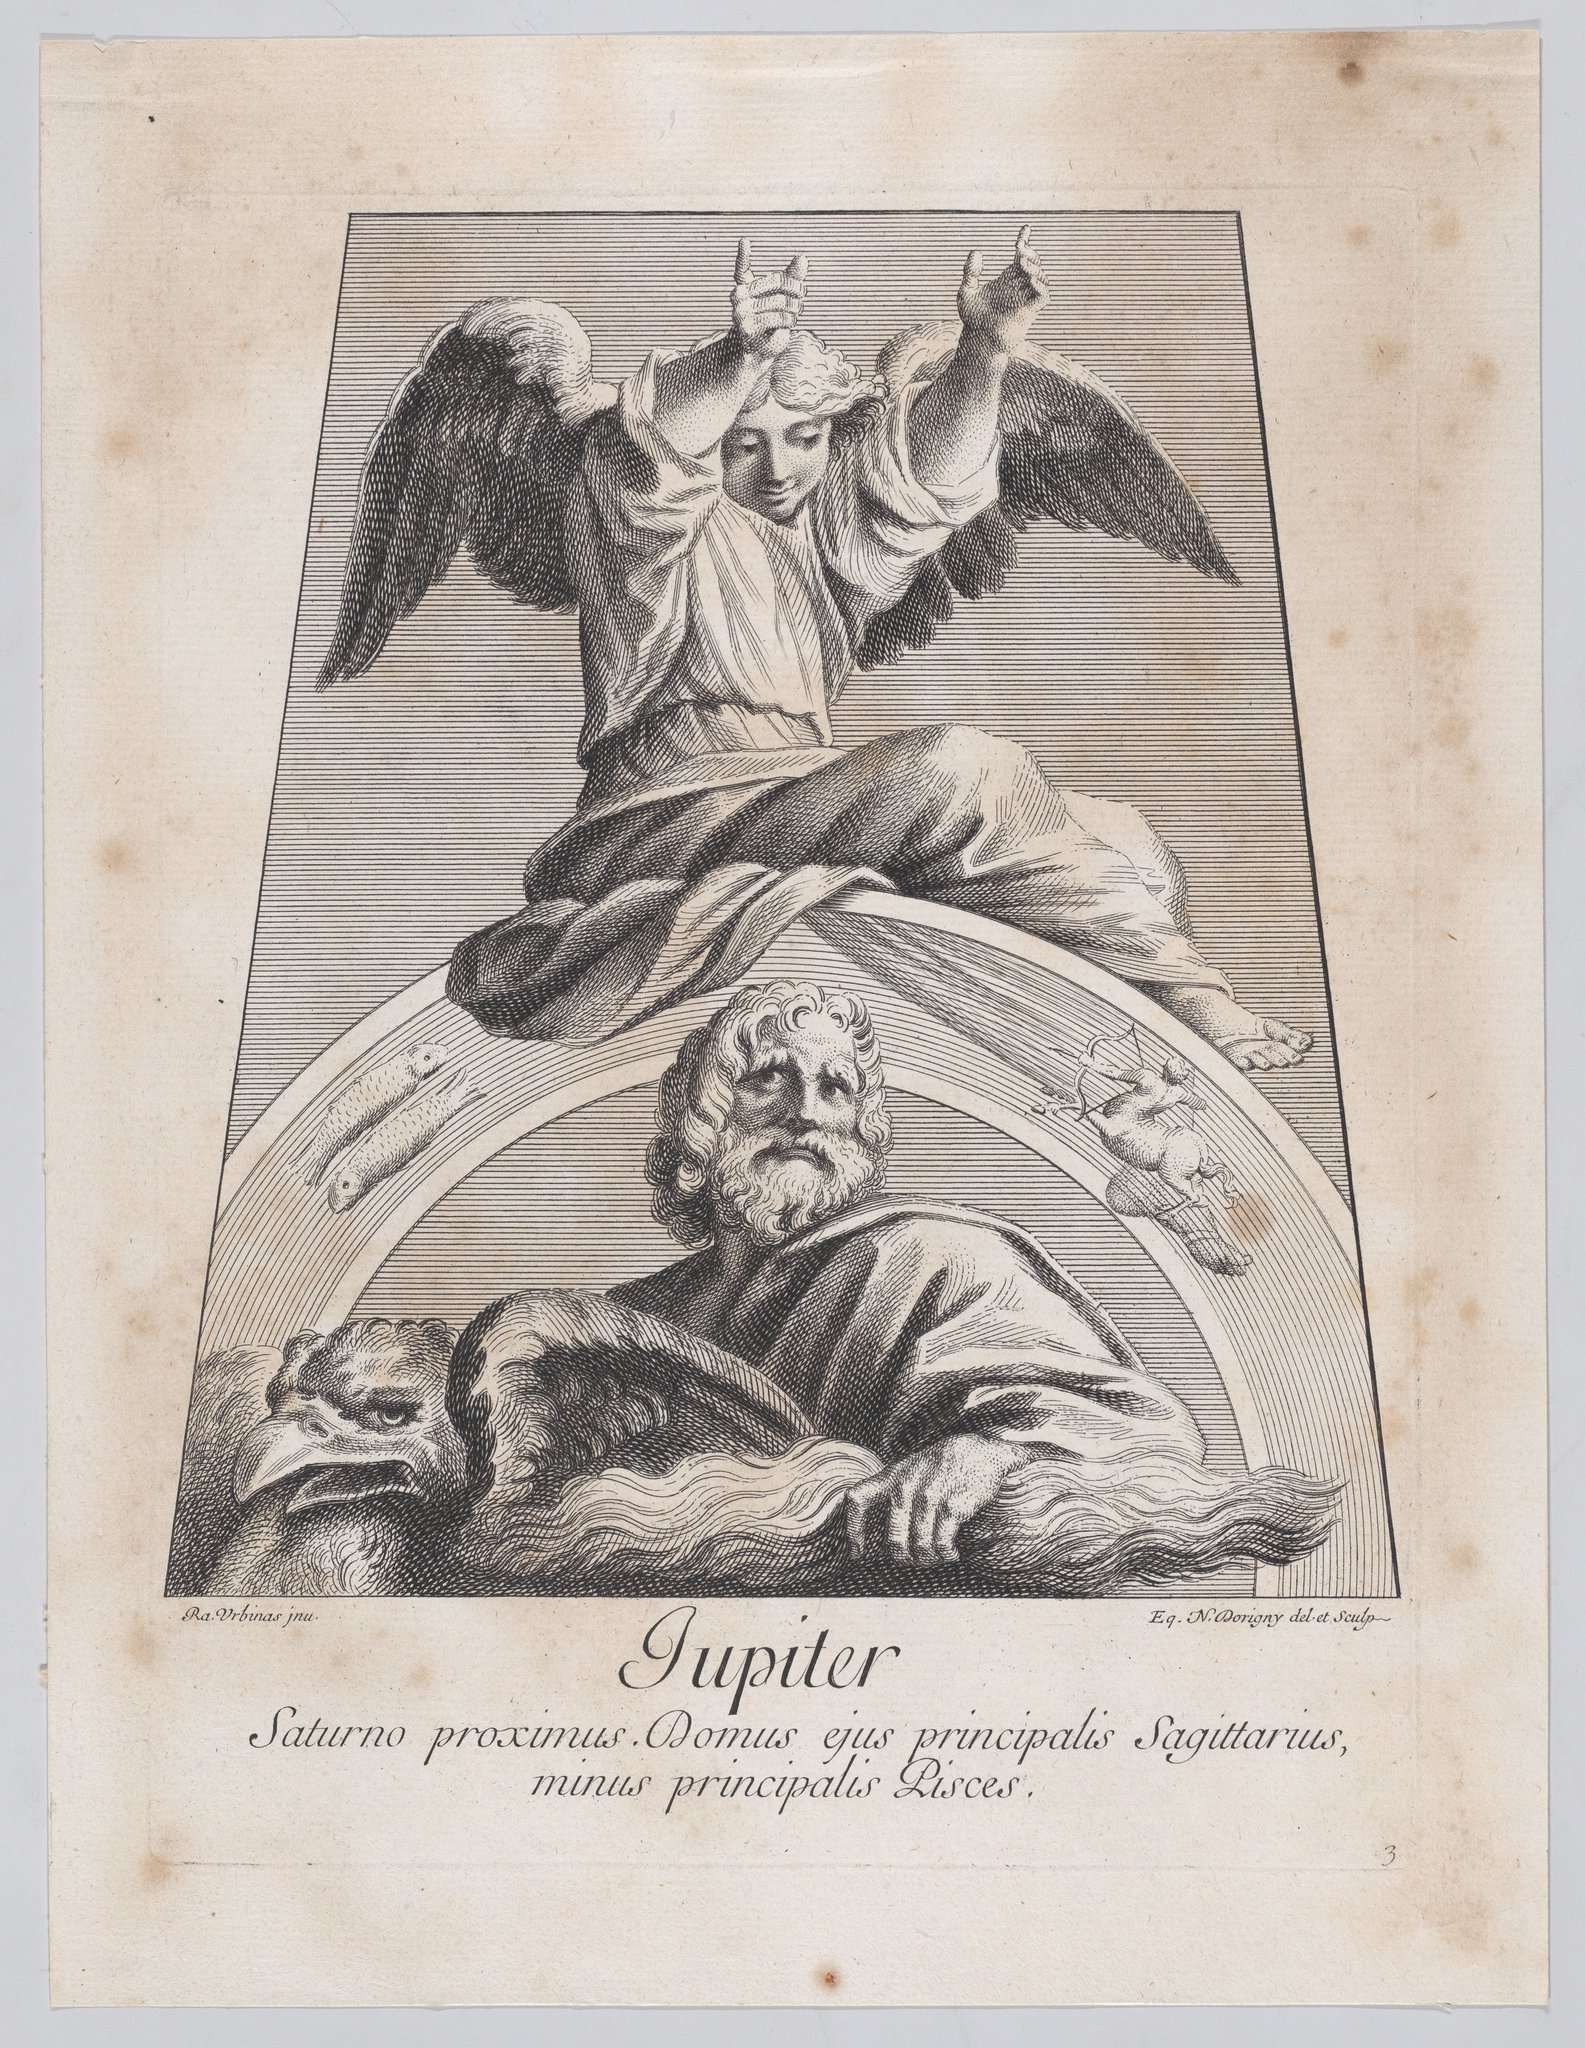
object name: print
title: Jupiter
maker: sir nicolas dorigny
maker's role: artist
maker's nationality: french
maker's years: 1655-1746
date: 1695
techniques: engraving